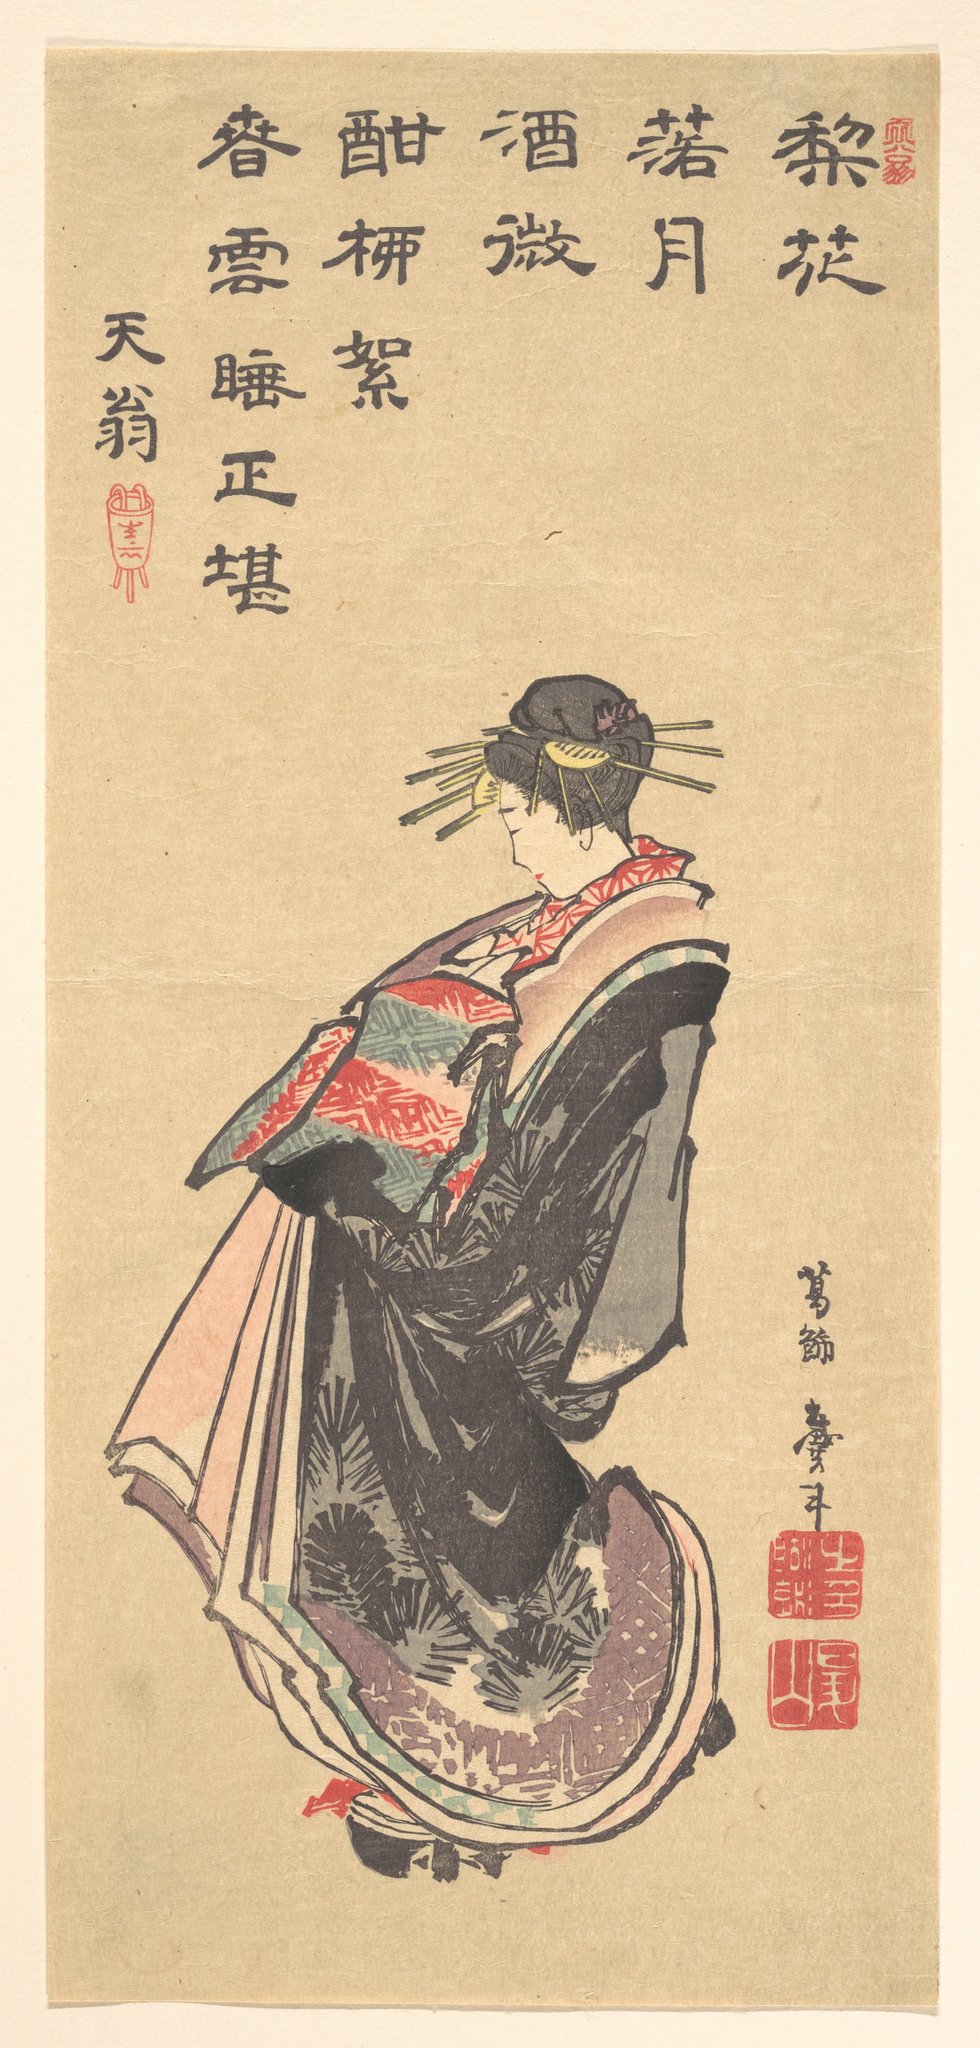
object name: woodblock print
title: A Courtesan on Parade, Dressed in Many Robes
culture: japanese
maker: katsushika hokusai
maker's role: artist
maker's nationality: japanese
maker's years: 1760-1849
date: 1760-1849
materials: ink, paper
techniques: woodblock print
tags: women